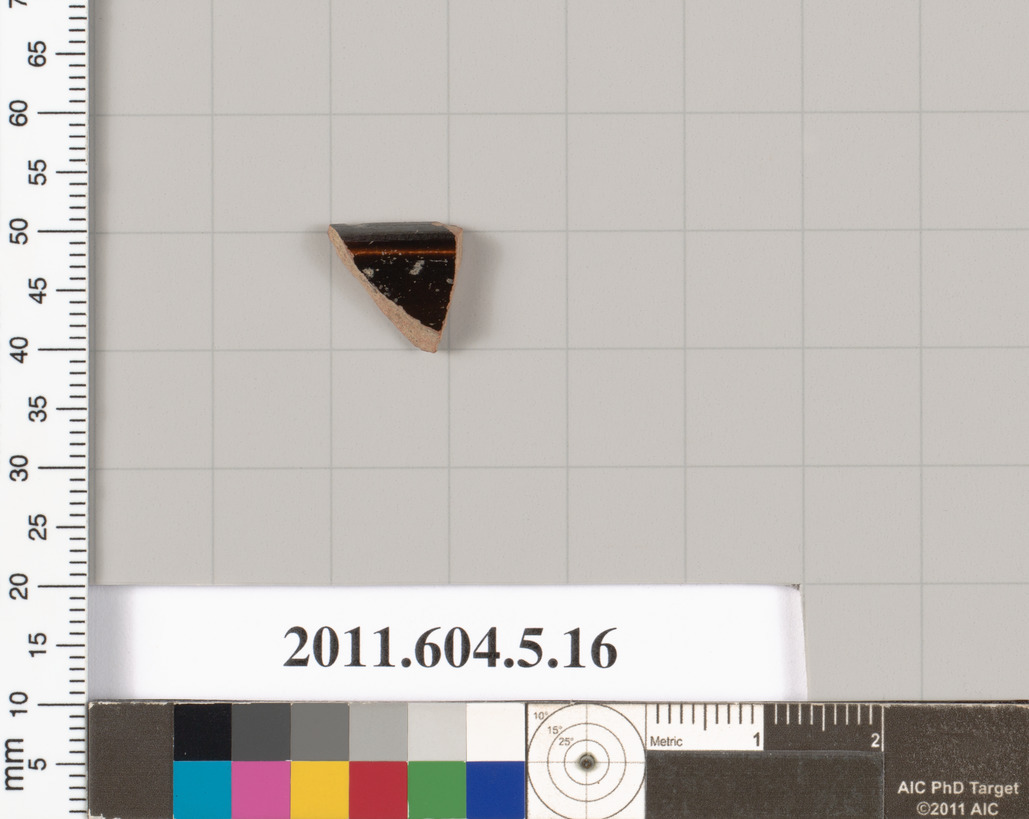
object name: kylix fragment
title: Terracotta rim fragment of a kylix (drinking cup)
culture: greek, attic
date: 500-401 BCE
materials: terracotta